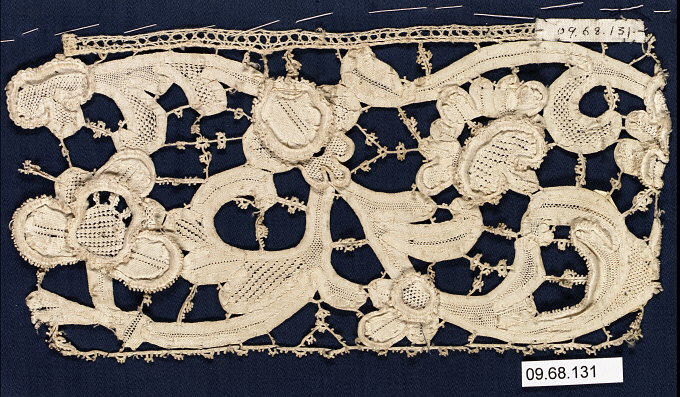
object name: specimen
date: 1601-1700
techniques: lace